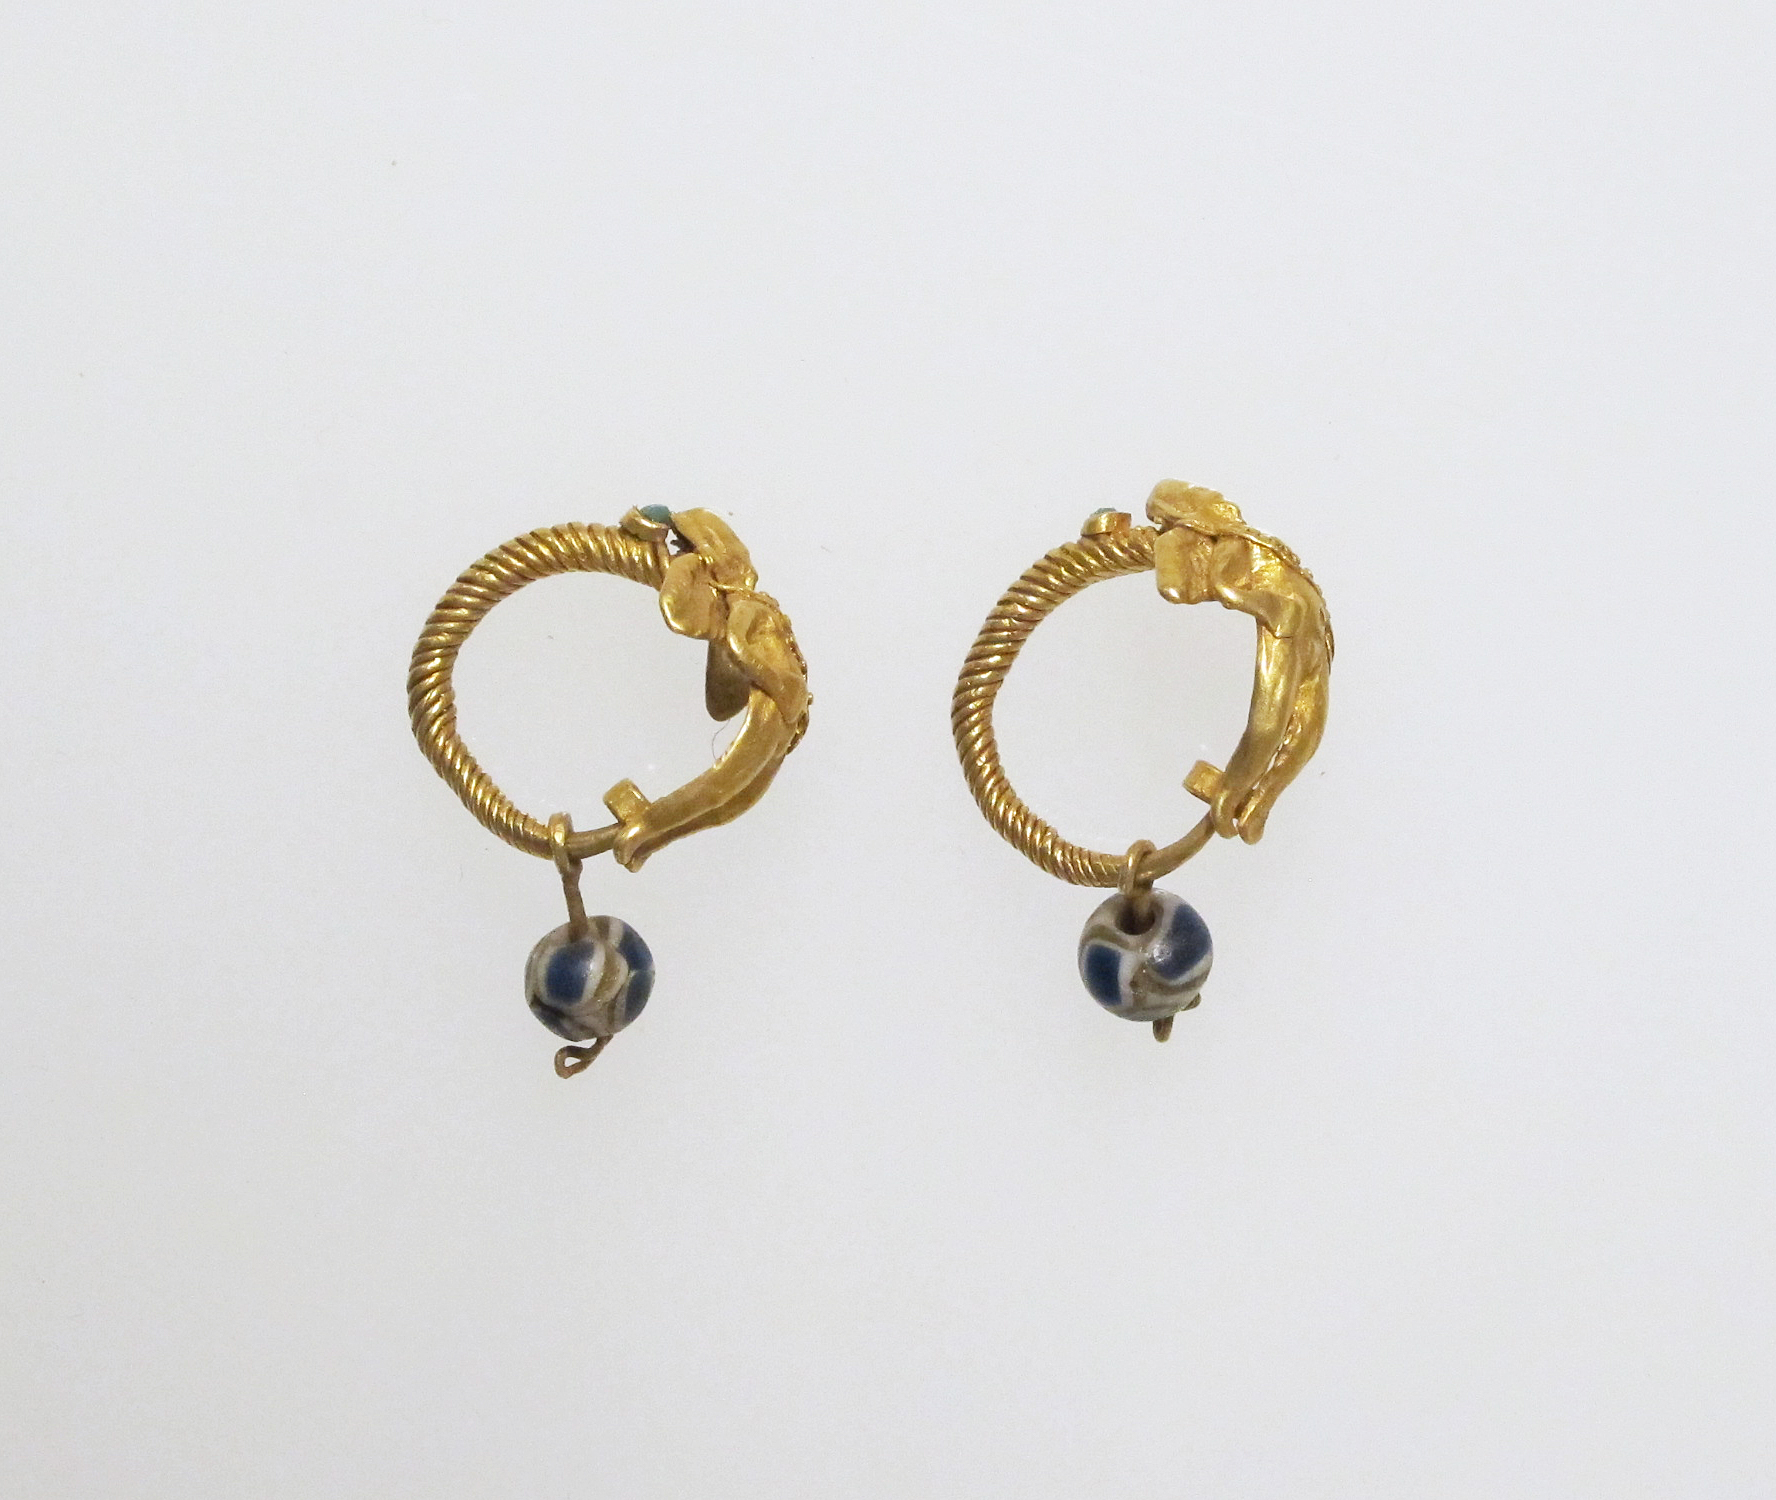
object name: earring with eros and paste bead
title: Earring with Eros and paste beads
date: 7000 BCE-330 CE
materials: glass, gold, paste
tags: eros